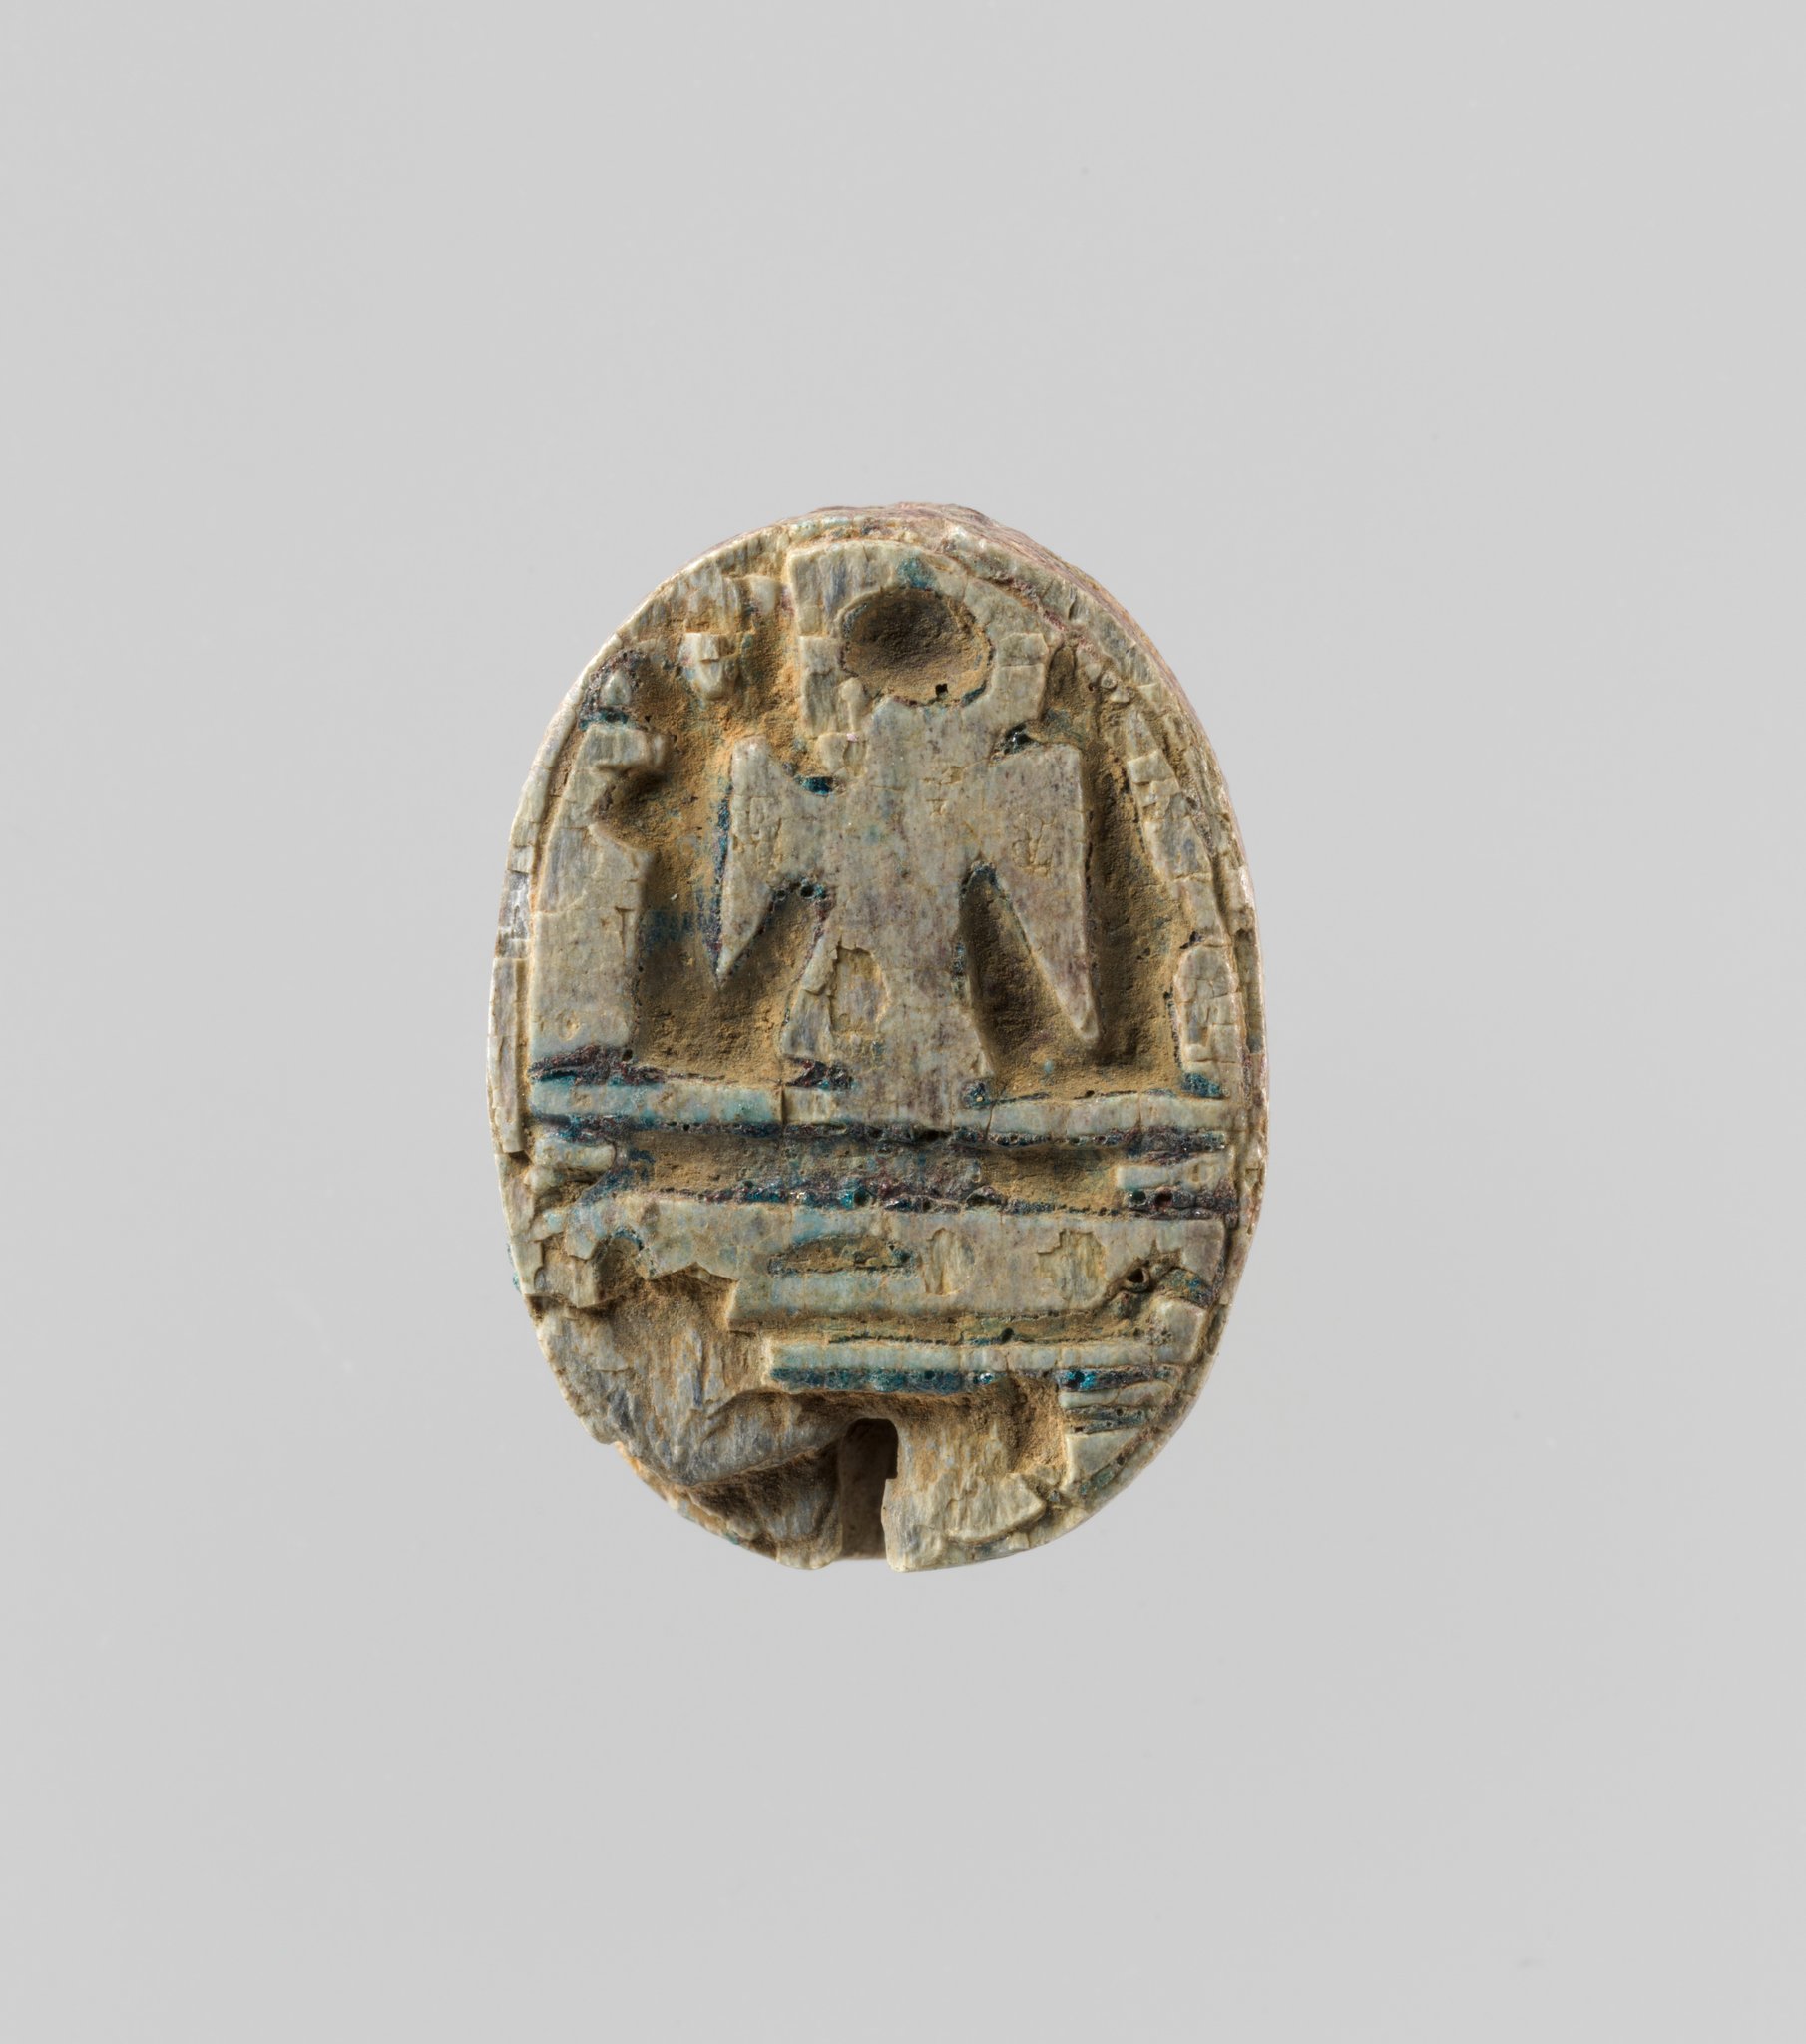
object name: scarab, sethnakht, royal name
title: Scarab Inscribed with the Name of Sethnakht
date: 1186-1184 BCE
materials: glaze, stone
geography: egypt